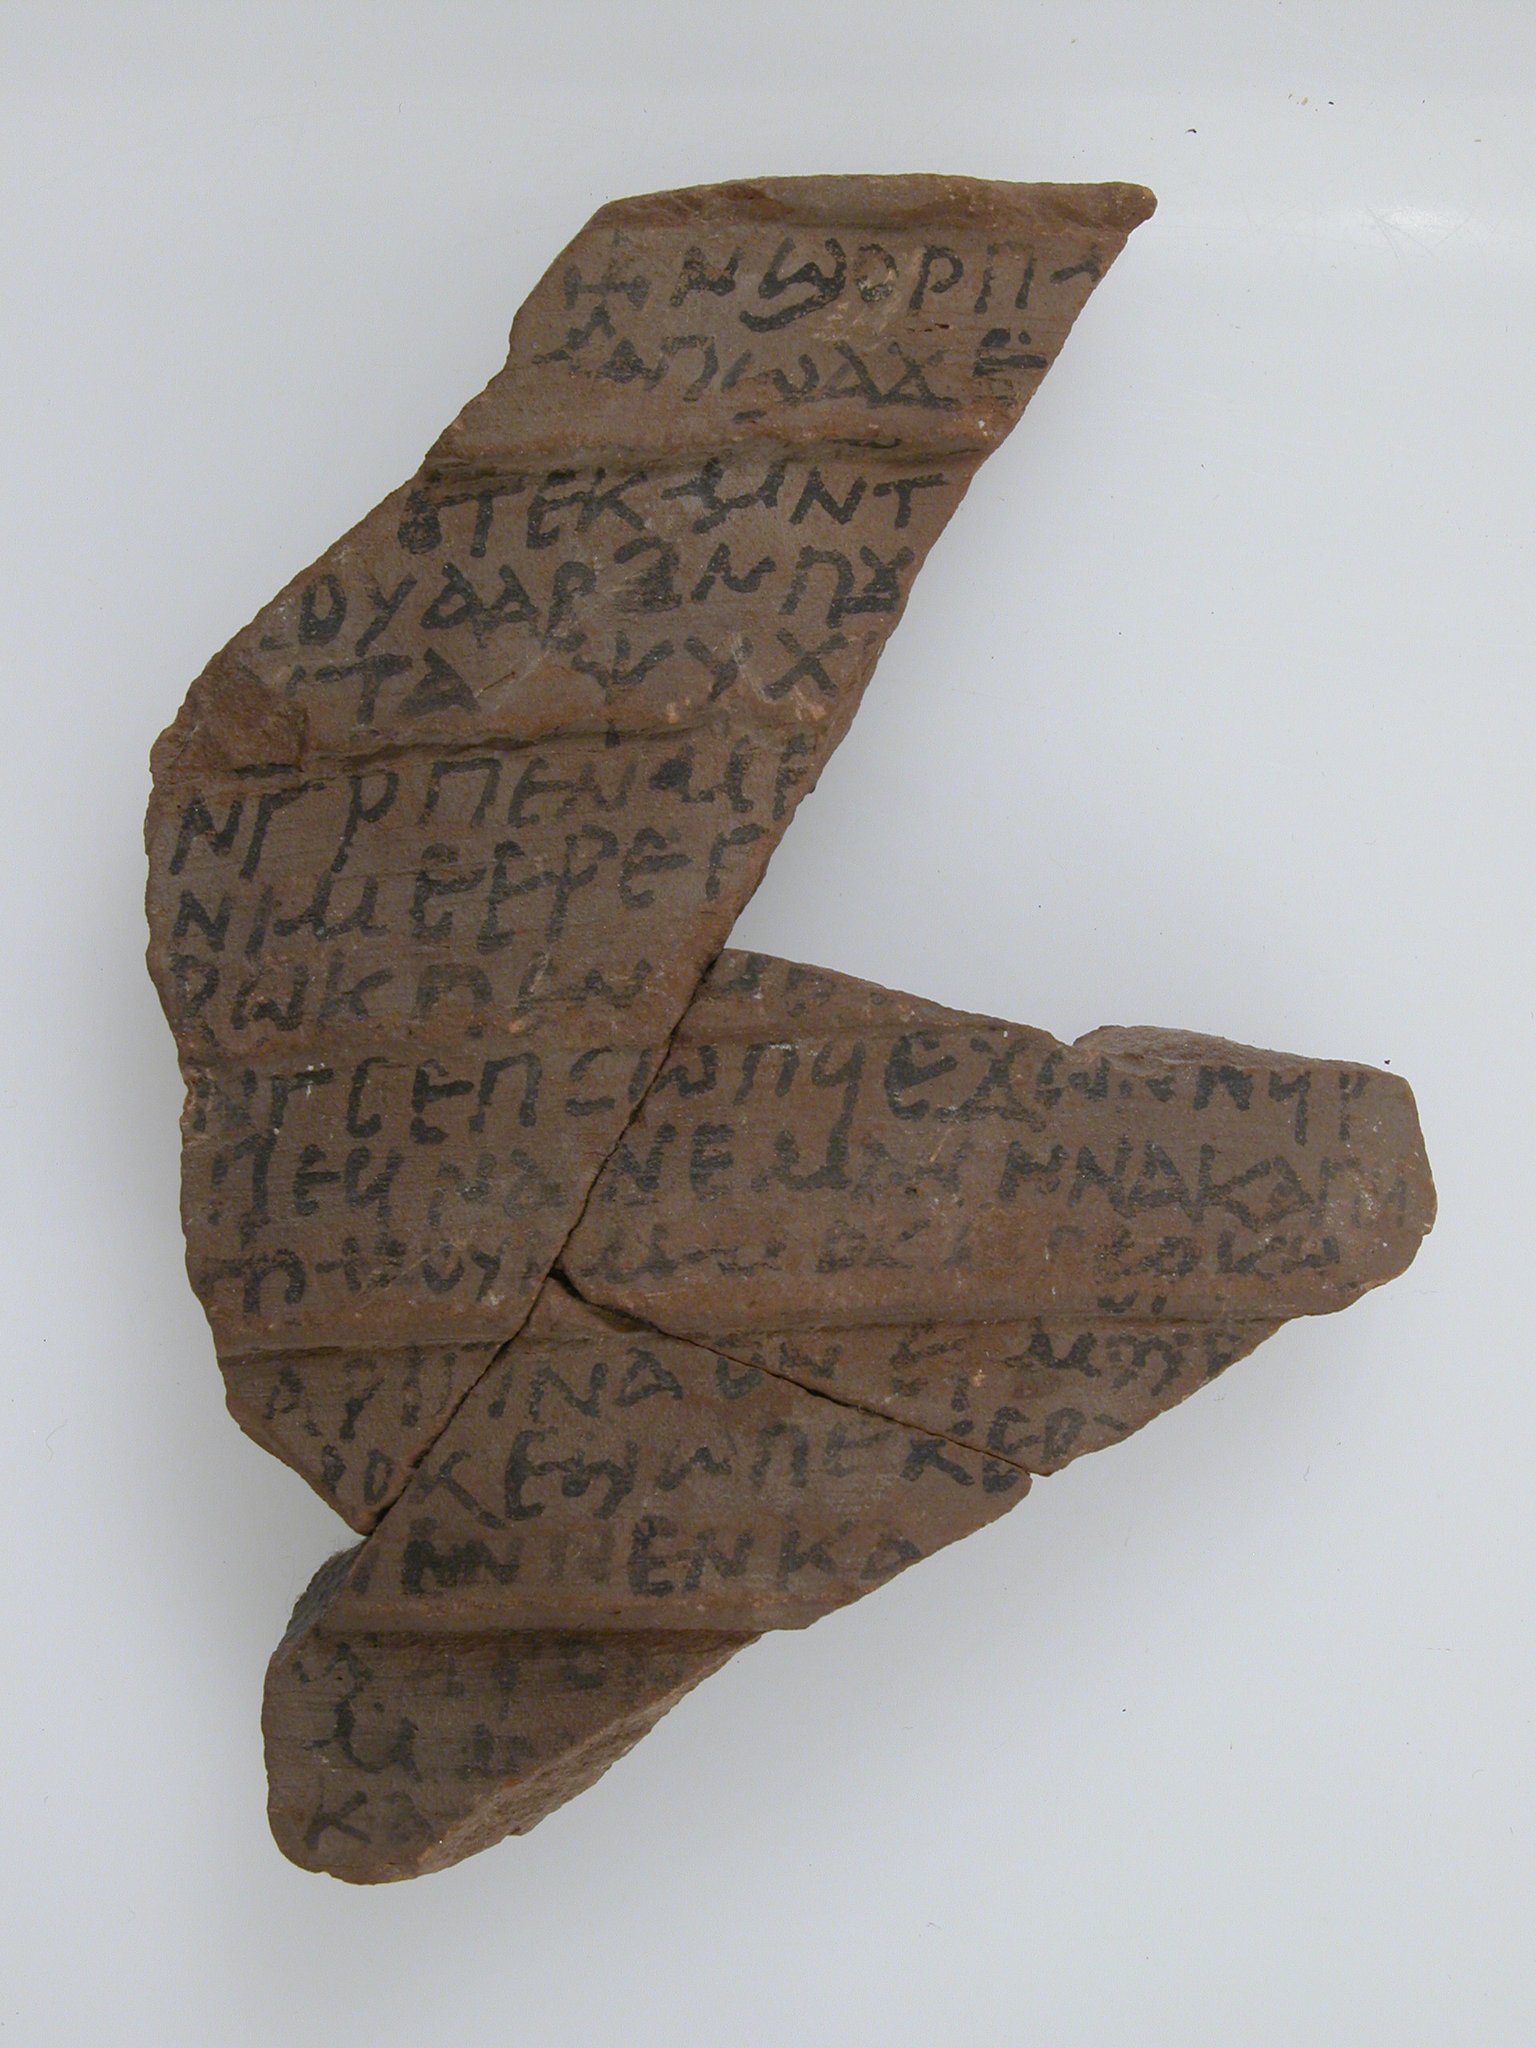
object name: ostrakon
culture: coptic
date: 601-700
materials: ink, pottery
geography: egypt